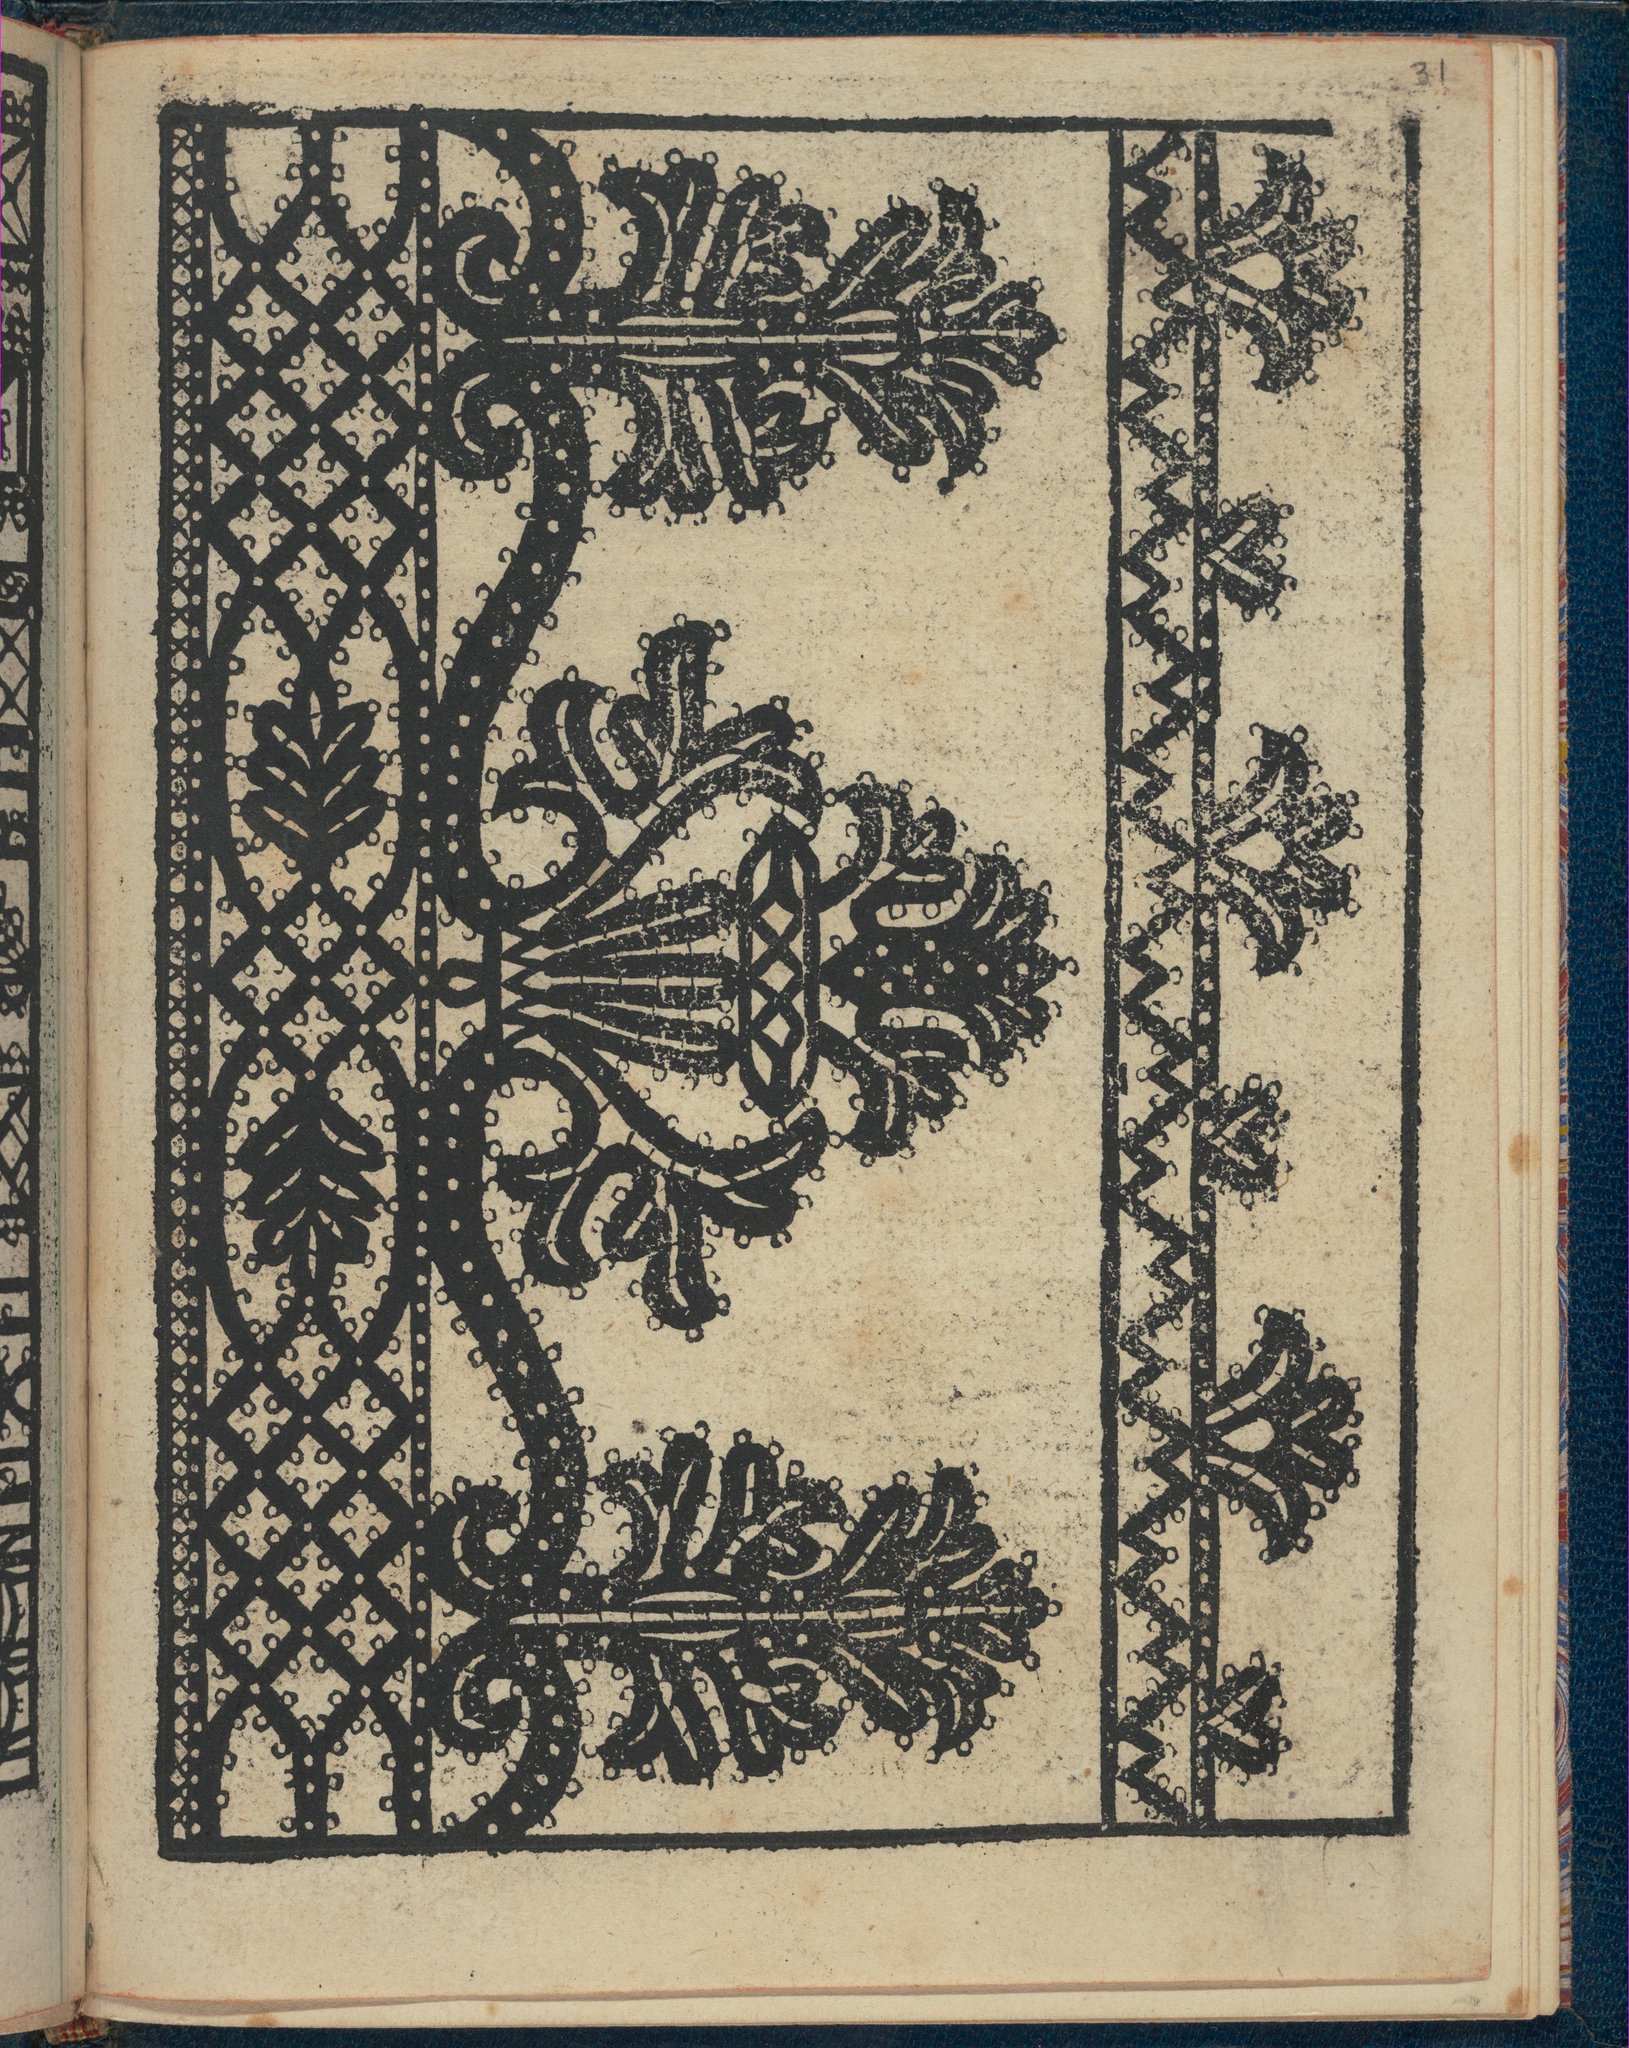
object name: book print ornament architecture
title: Le Pompe: Opera Nova, page 16 (recto)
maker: giovanni battista & marchio sessa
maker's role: publisher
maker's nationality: italian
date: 1557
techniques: woodcut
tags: leaves,vines